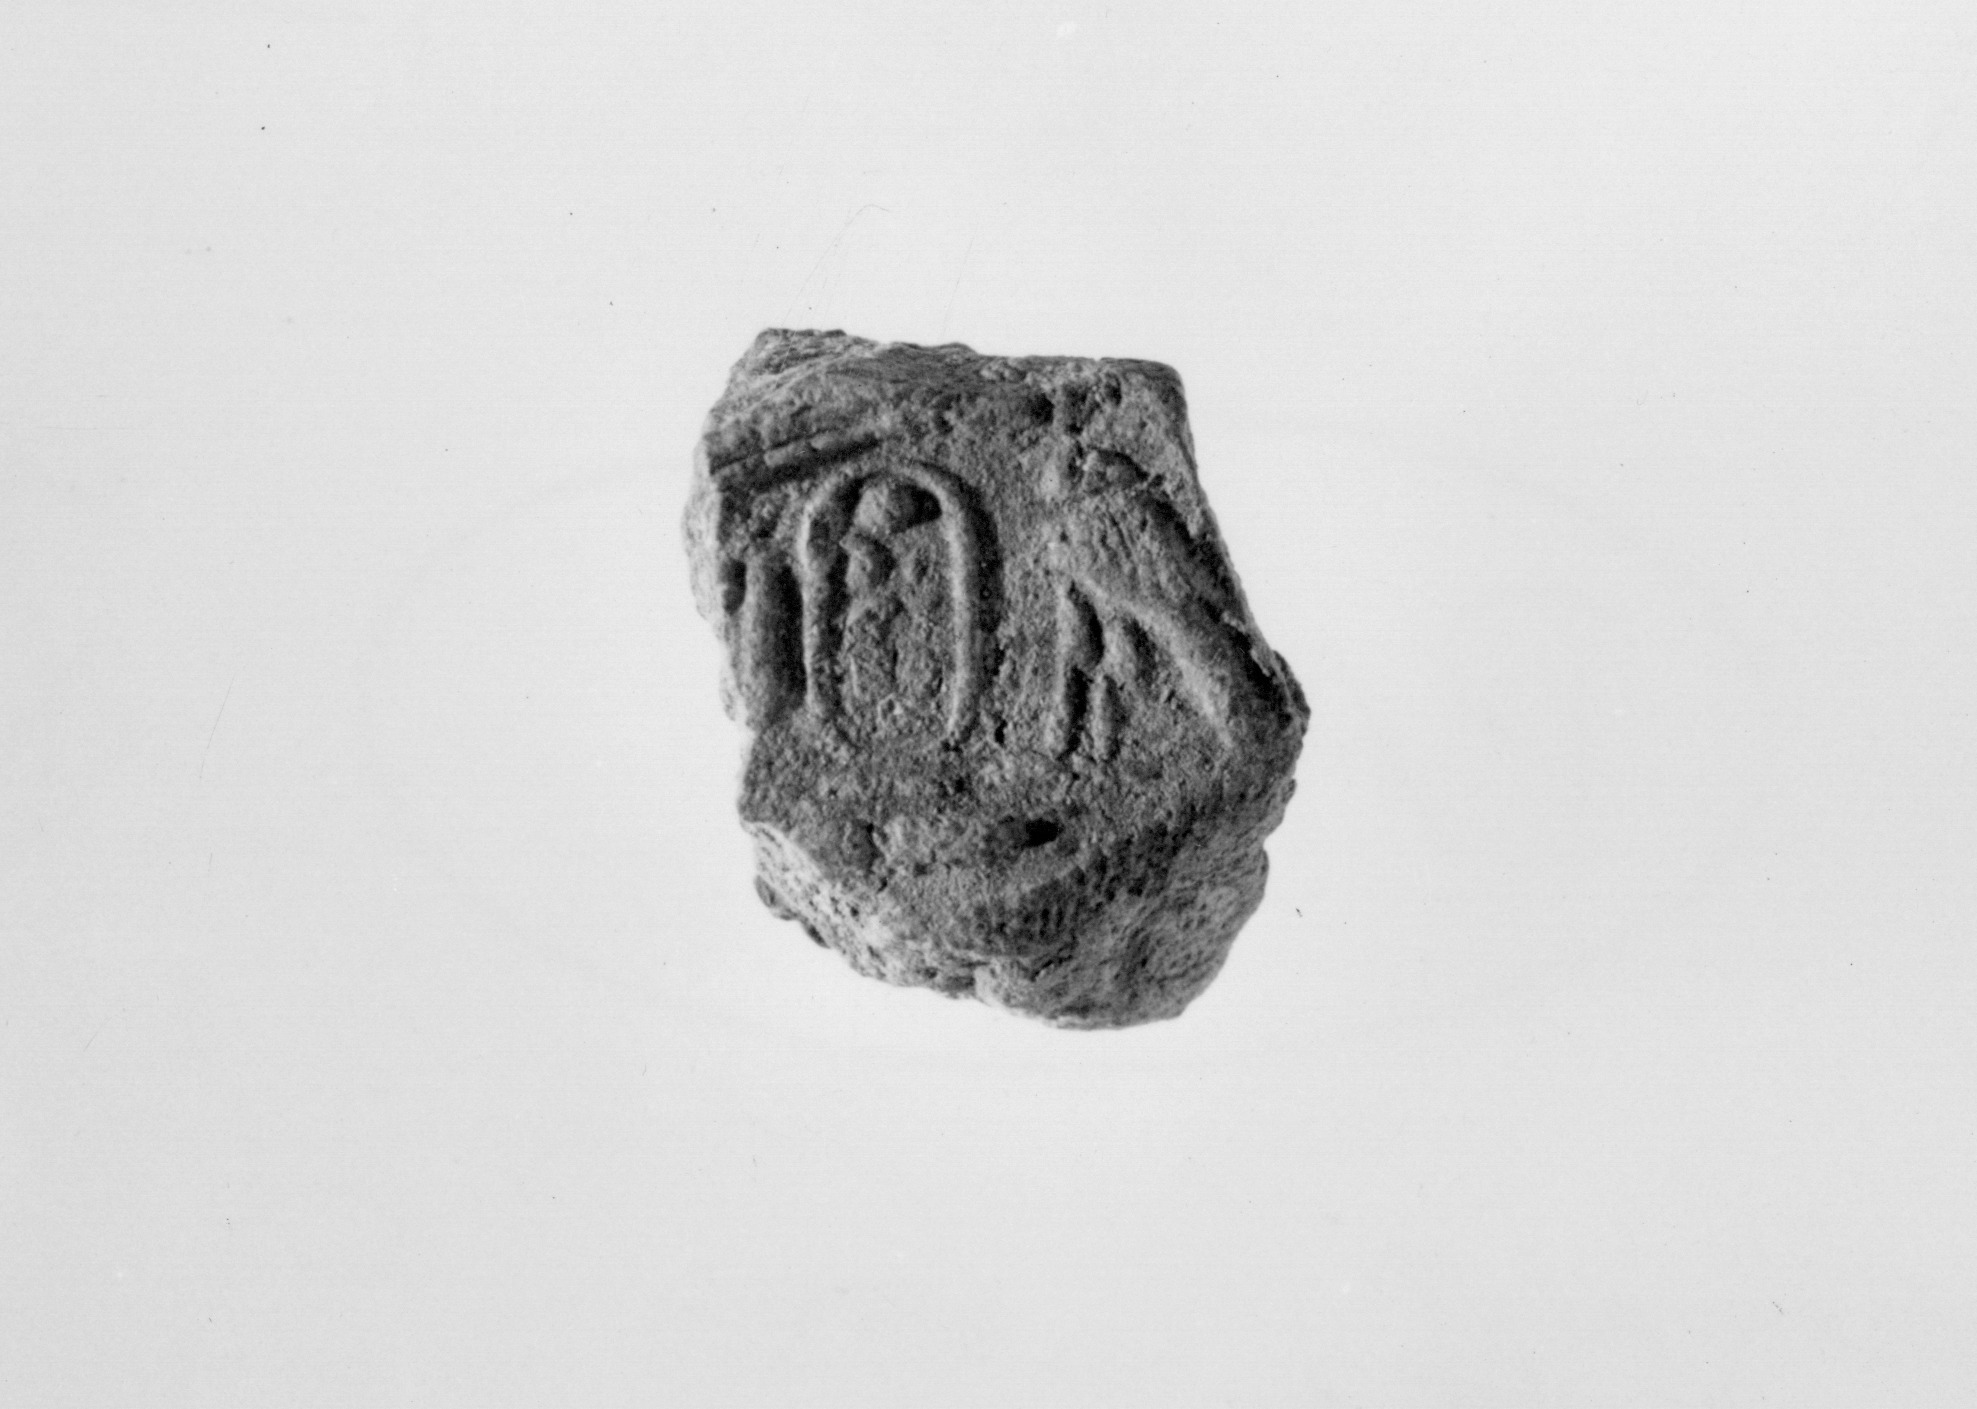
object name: sealing, nebmaatre, amenhotep iii, horus, falcon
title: Document Sealing With the Throne Name of Amenhotep III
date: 1390-1352 BCE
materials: mud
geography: egypt